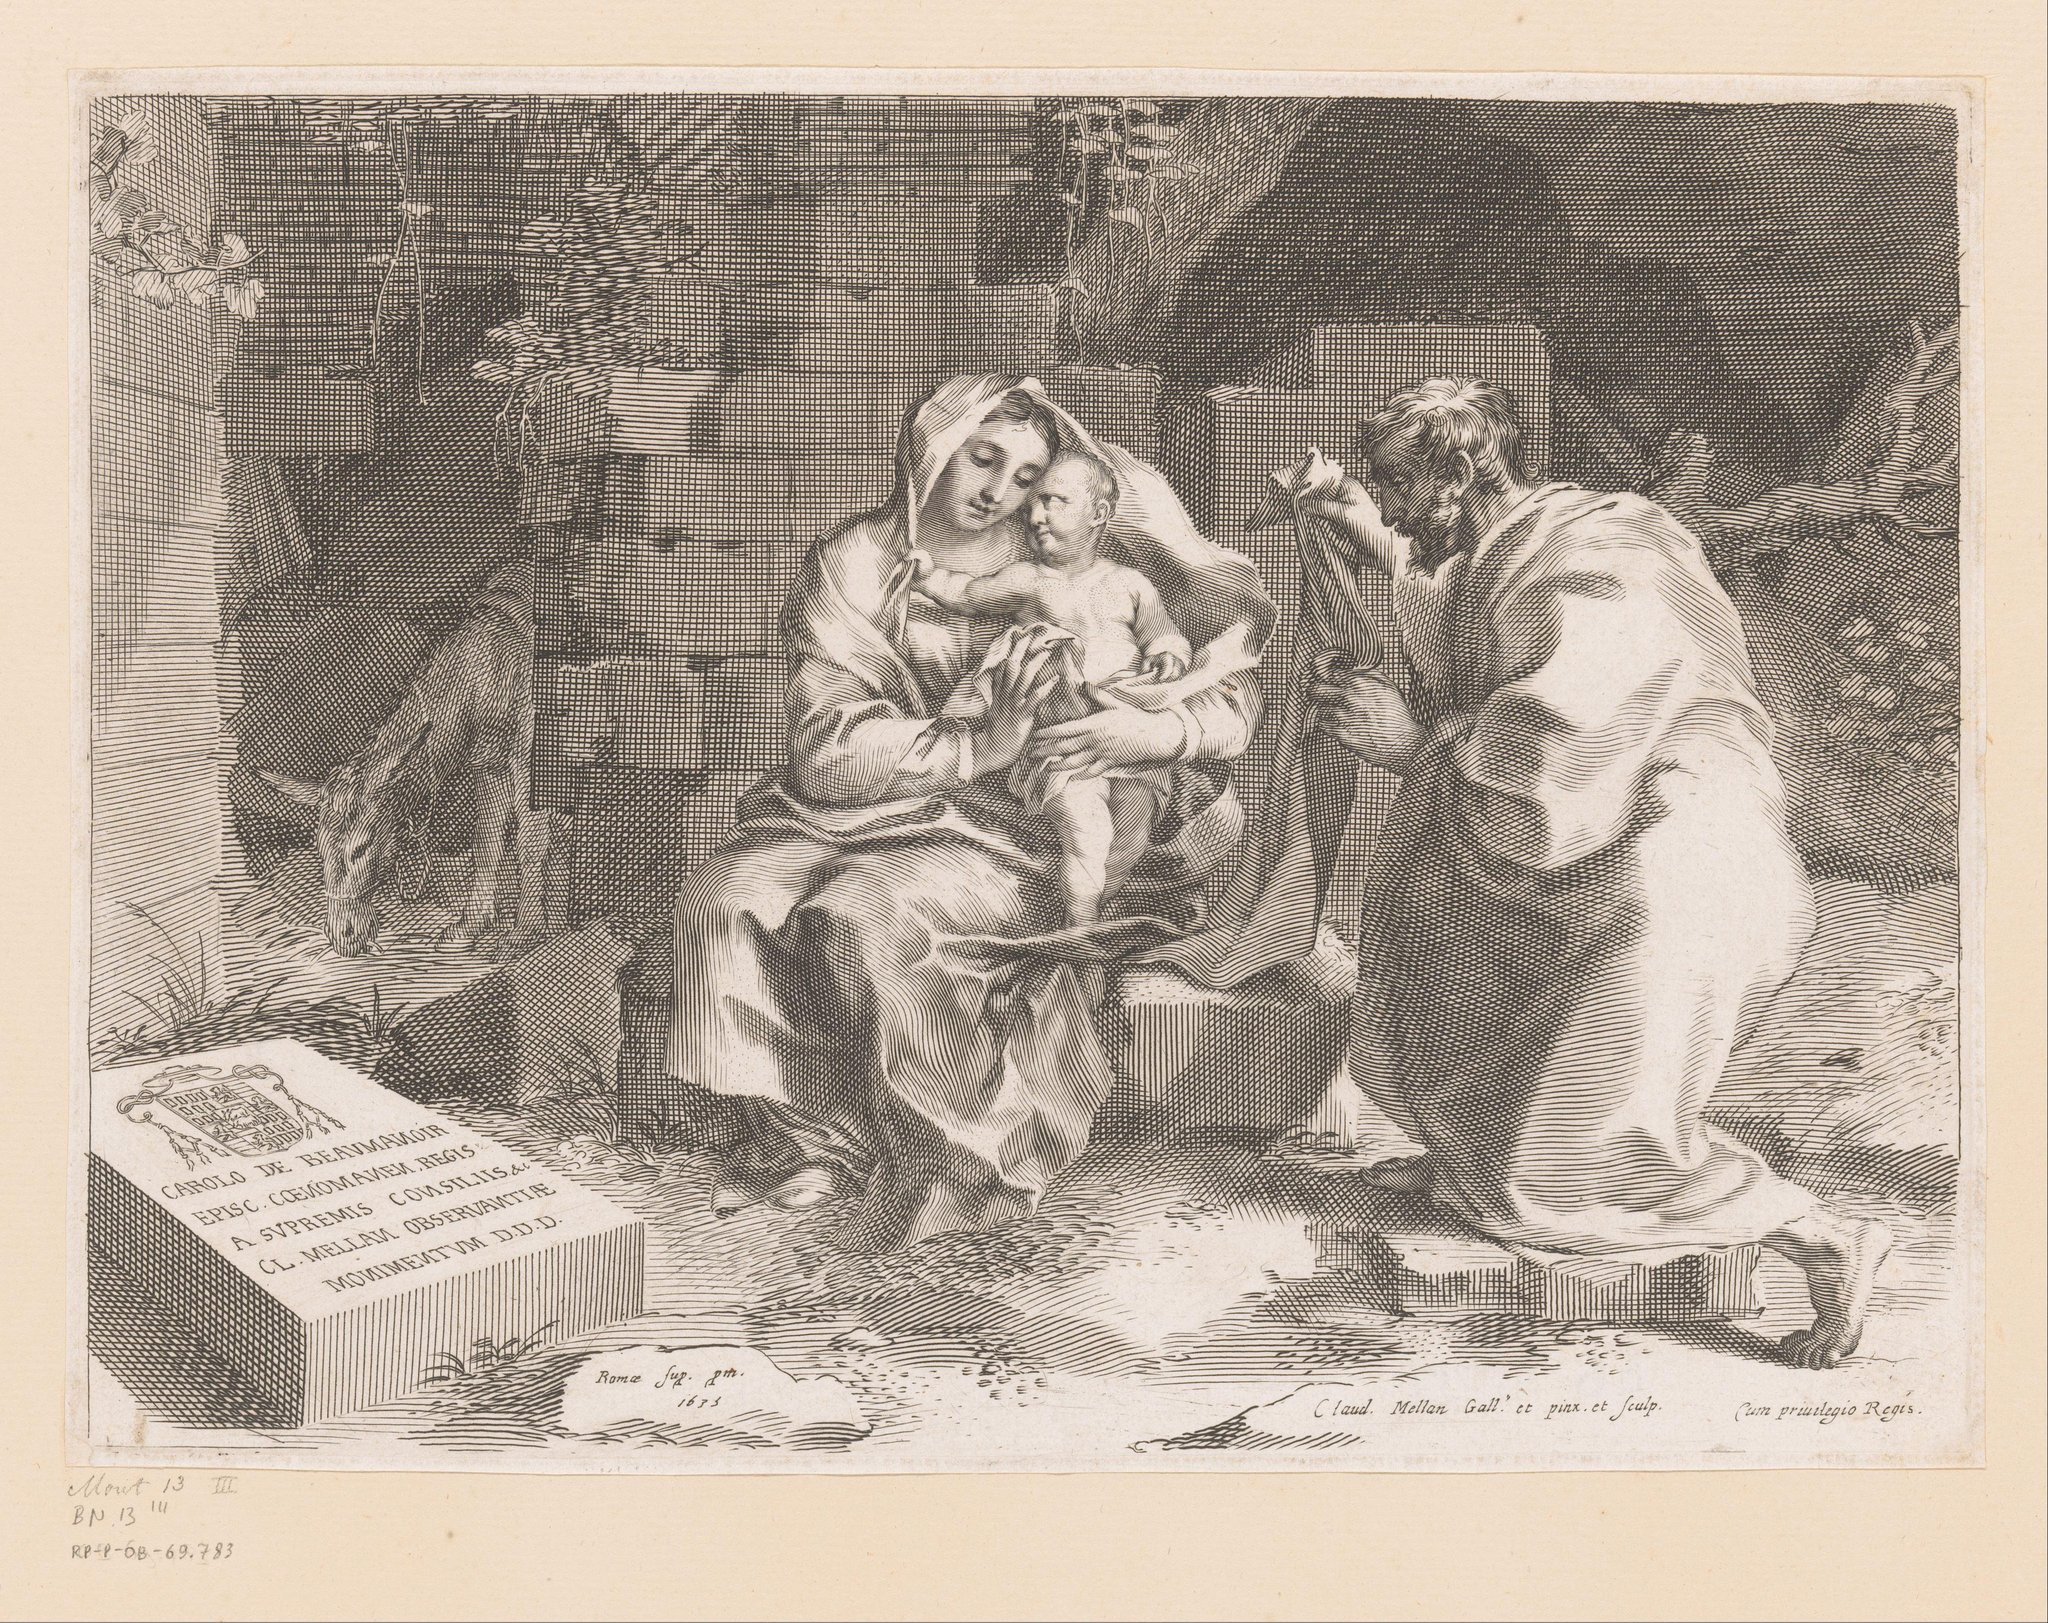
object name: print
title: Rust op de vlucht naar Egypte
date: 1635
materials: paper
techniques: engraving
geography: rome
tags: rest on the flight into egypt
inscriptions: collector's mark: Lugt 240